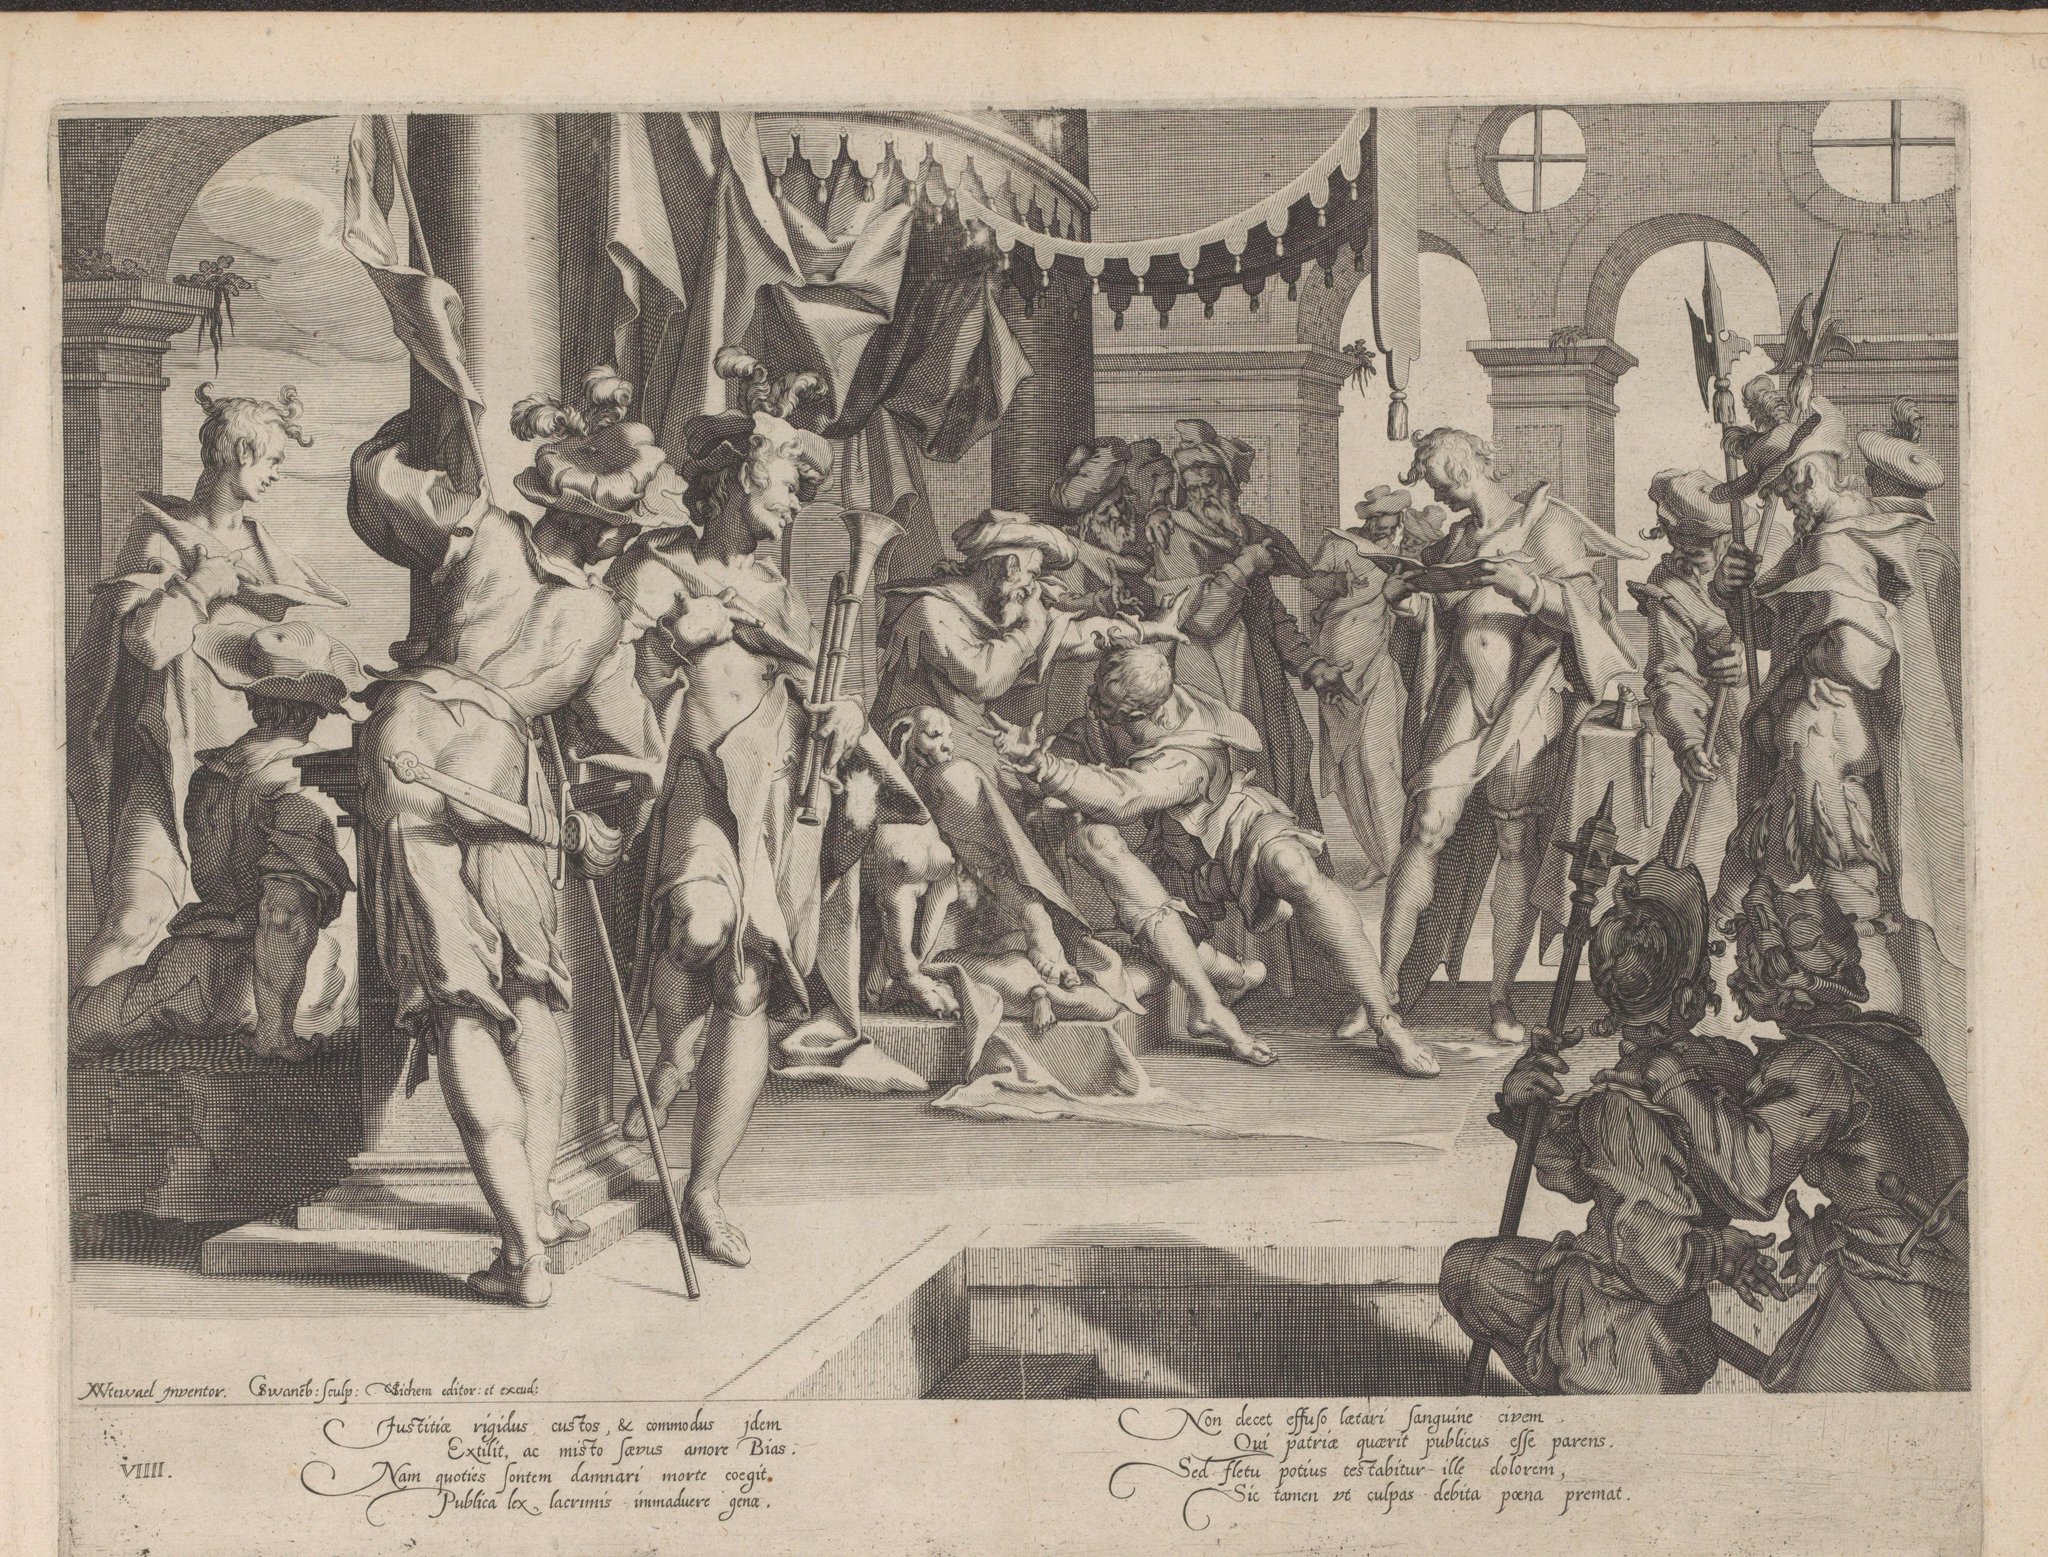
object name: album leaf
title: Thronus Justitiae duodecim pulcherrimis tabulis artificiosissime aeri incisis illustratus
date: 1606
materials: paper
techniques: engraving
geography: amsterdam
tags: bias weeps when he has to condemn a man, juridical examples; exemplary judges; 'gerechtigkeitsbilder'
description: Terwijl het doodvonnis over een veroordeelde wordt voorgelezen, huilt rechter Bias uit empathie met de veroordeelde en zijn familie. De man smeekt de rechter, maar Bias laat het recht zegevieren ondanks zijn bewogenheid. Onder de voorstelling twee vierregelige verzen in het Latijn. De prent maakt deel uit van een album.